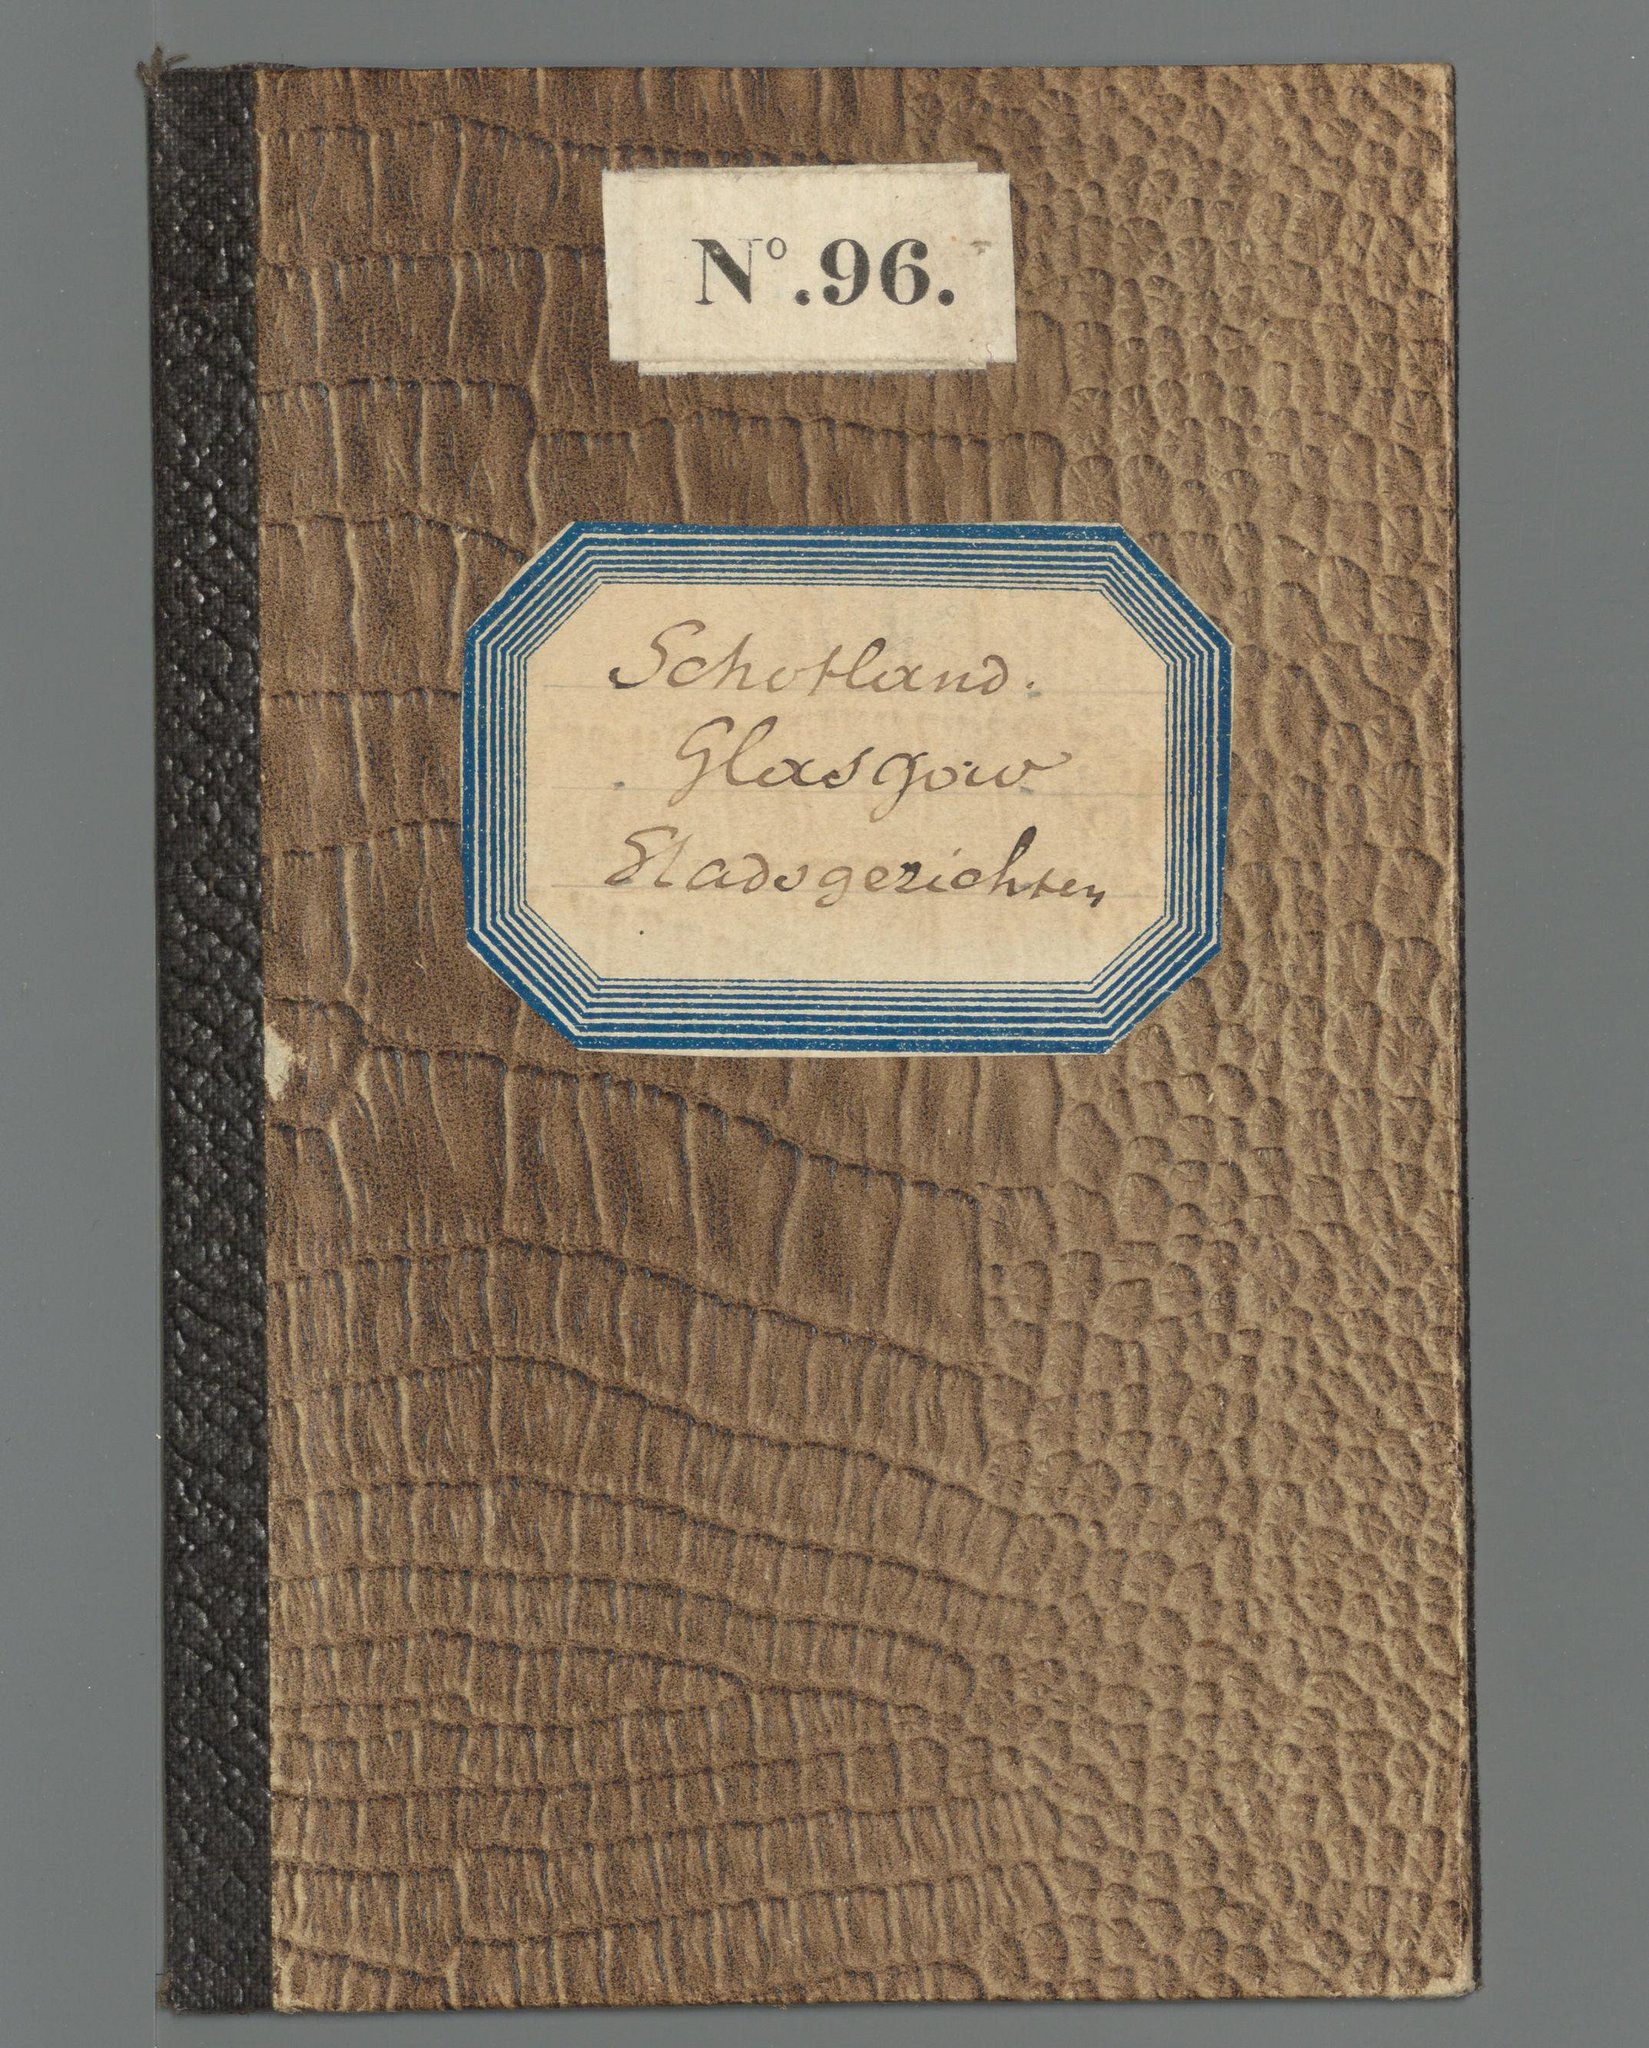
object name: wrapper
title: Omslag voor twintig prentbriefkaarten met stadsgezichten van Schotland en Glasgow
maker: Anonymous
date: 1900-1950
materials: cardboard, paper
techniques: lithograph, writing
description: In de omslag zit een kaart ingestoken met daarop een korte beschrijving van de inhoud.